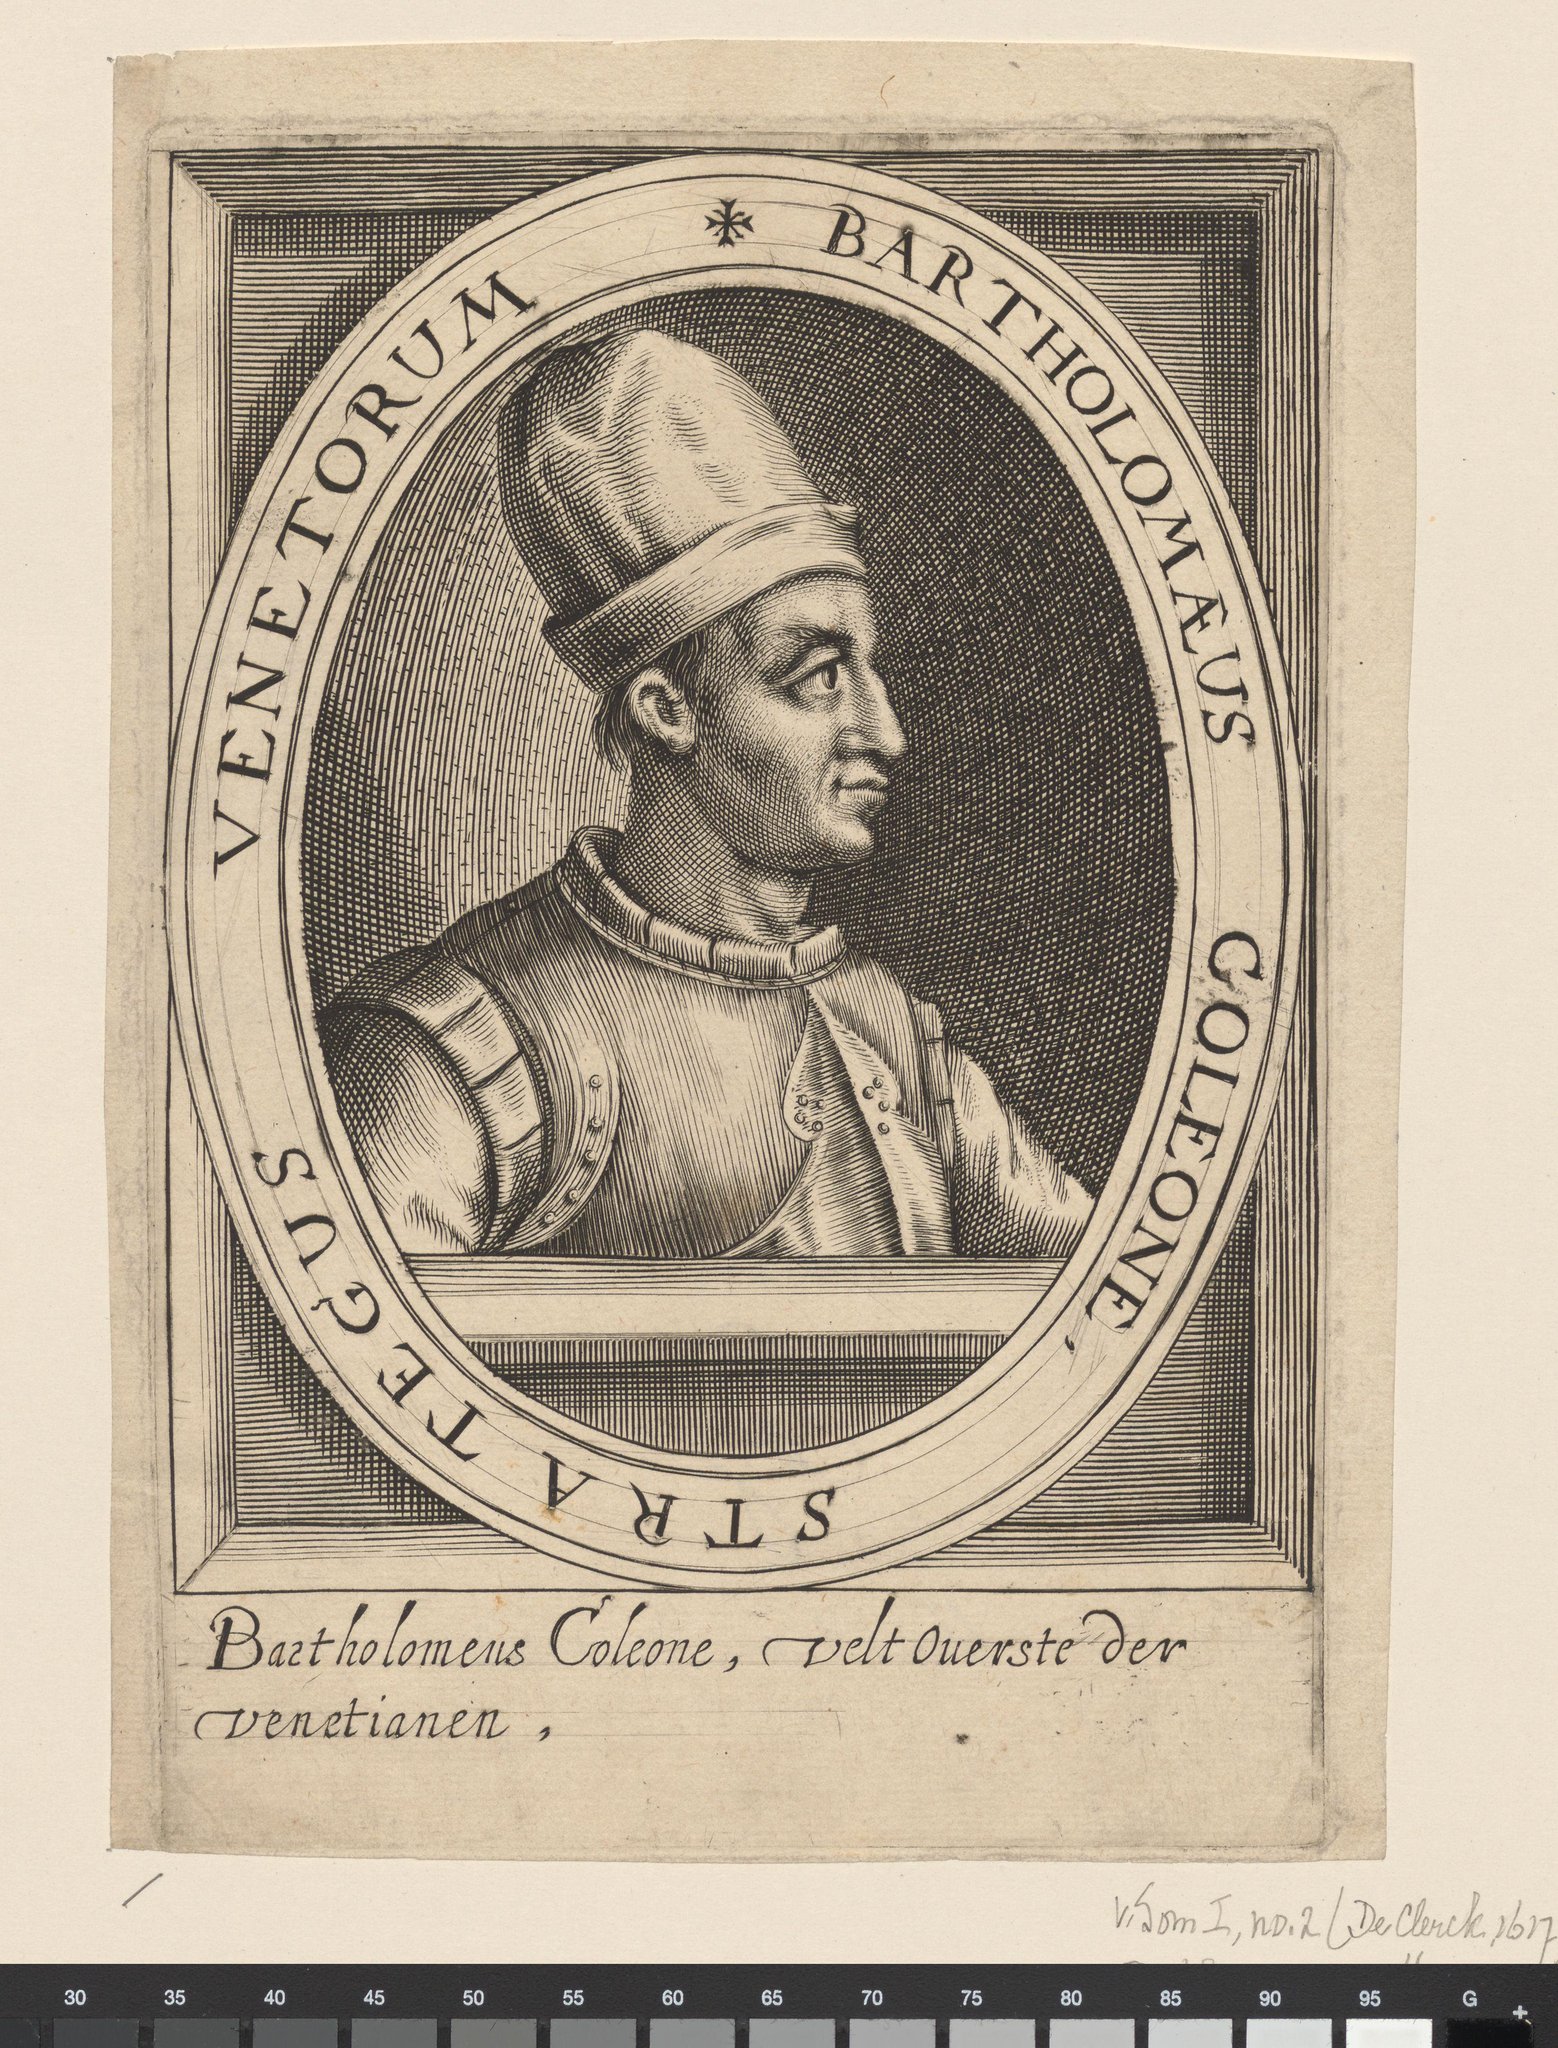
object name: print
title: Portret van Bartolomeo Colleoni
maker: Anonymous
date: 1617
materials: paper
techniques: engraving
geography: northern netherlands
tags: commander-in-chief, general, marshal, historical persons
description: Prent waarschijnlijk uit: Tooneel der beroemder hertogen princen graven ende krygs-helden van christenrijck binnen deze drij laetste eeuwen. Delft: Nicolaes de Clerck, 1617.